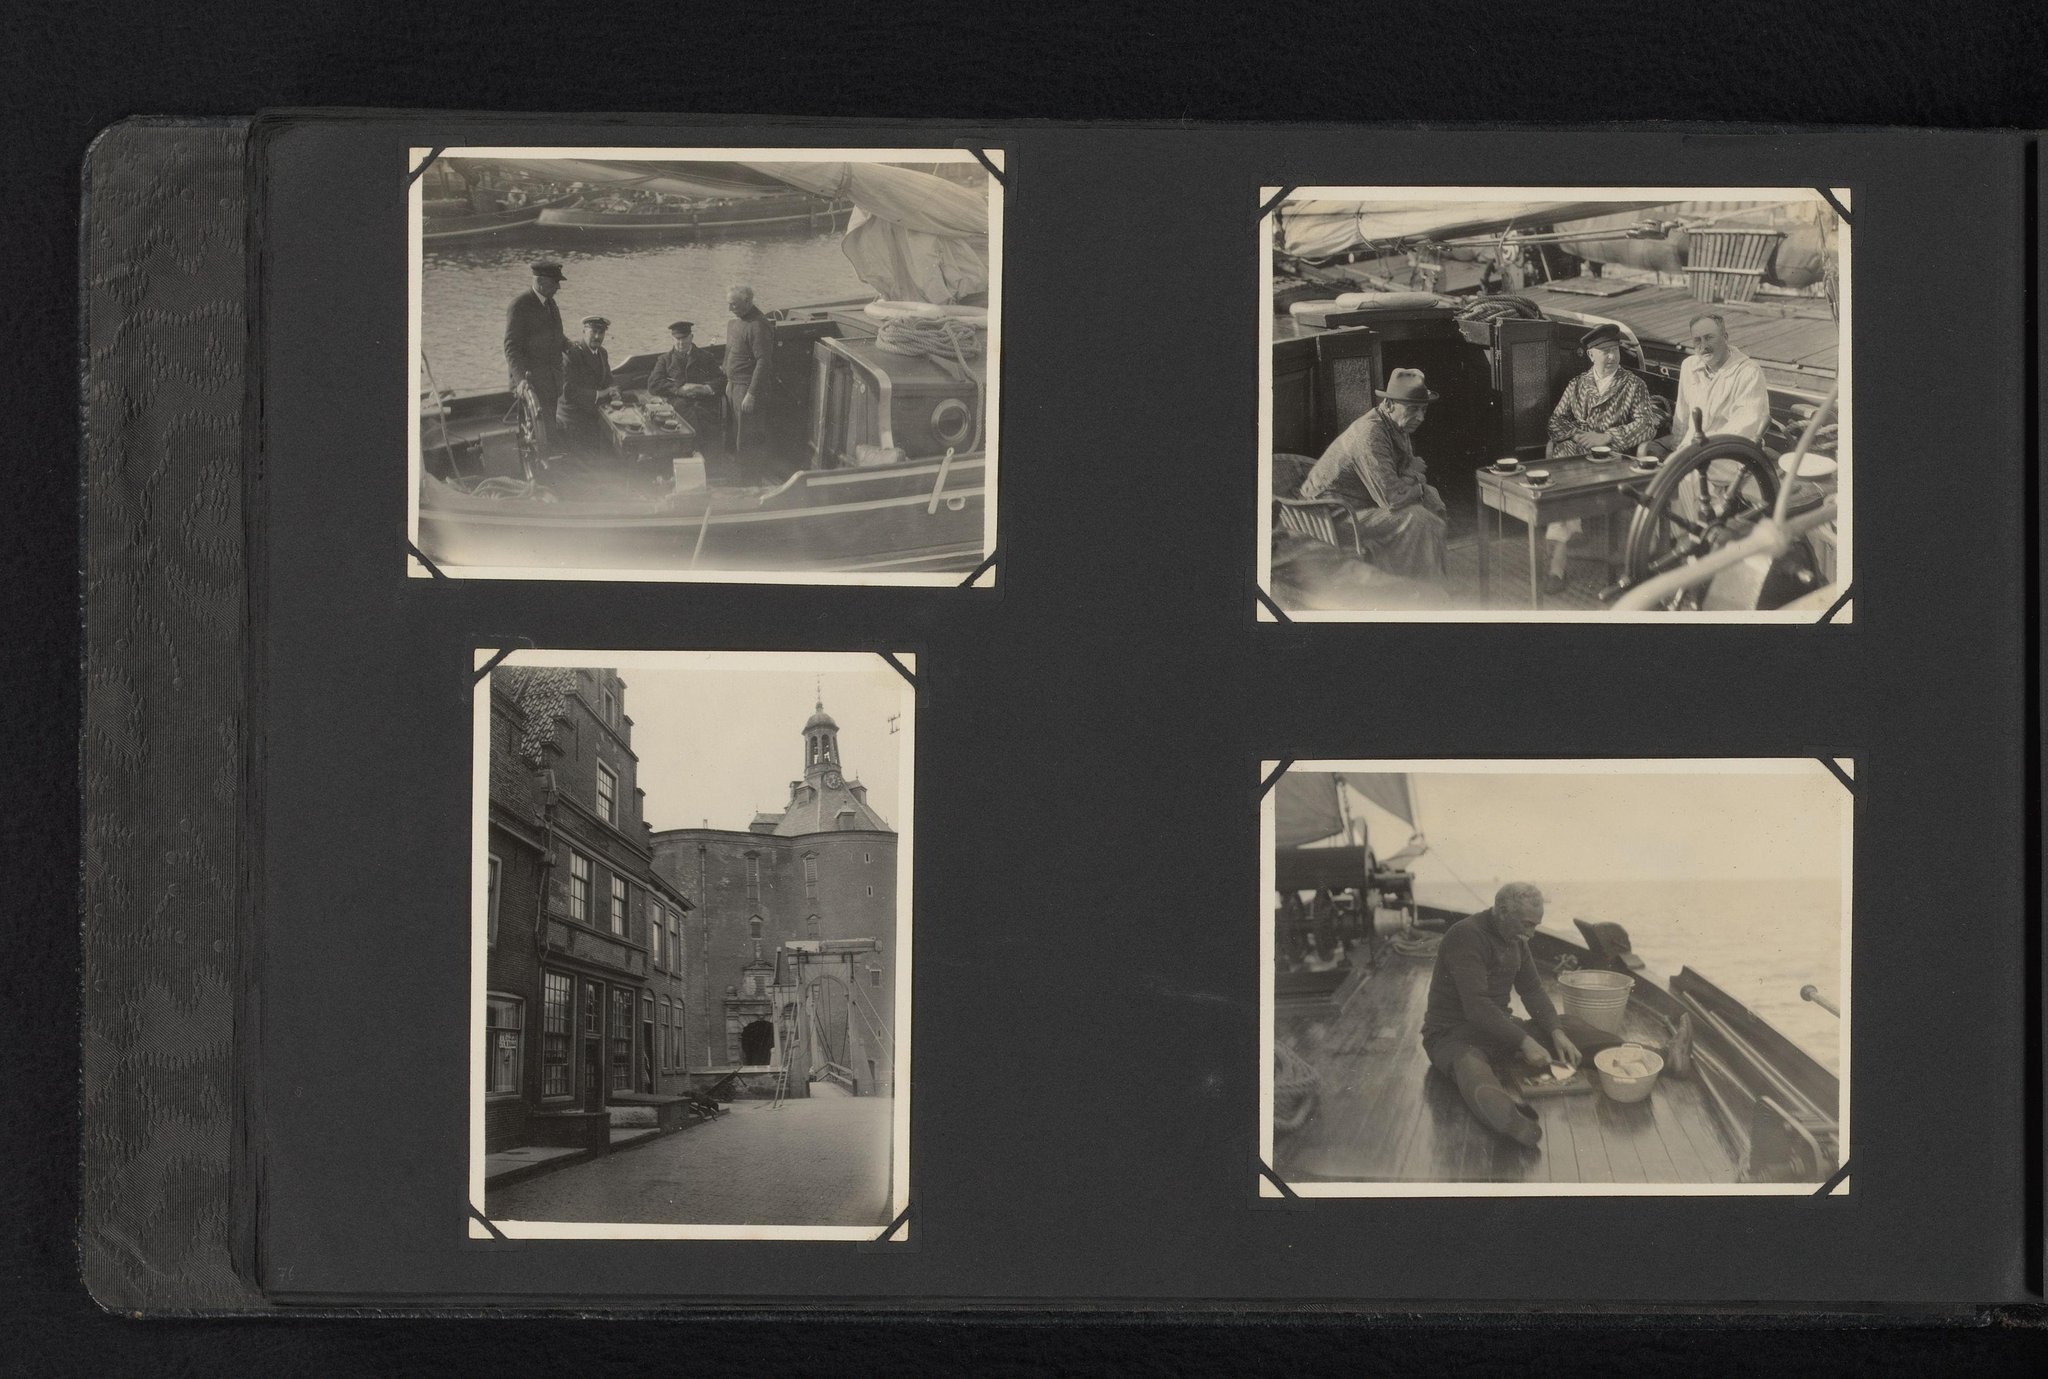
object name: album leaf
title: Vier foto's van mannen aan boord van een zeilboot en een toren in Nederland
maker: hendrik herman van den berg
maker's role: amateurfotograaf, jurist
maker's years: 1875-1944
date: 1929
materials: paper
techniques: gelatin silver print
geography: netherlands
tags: sailing-ship, sailing-boat, gate, entrance, netherlands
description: Deze foto's maken deel uit van een album.